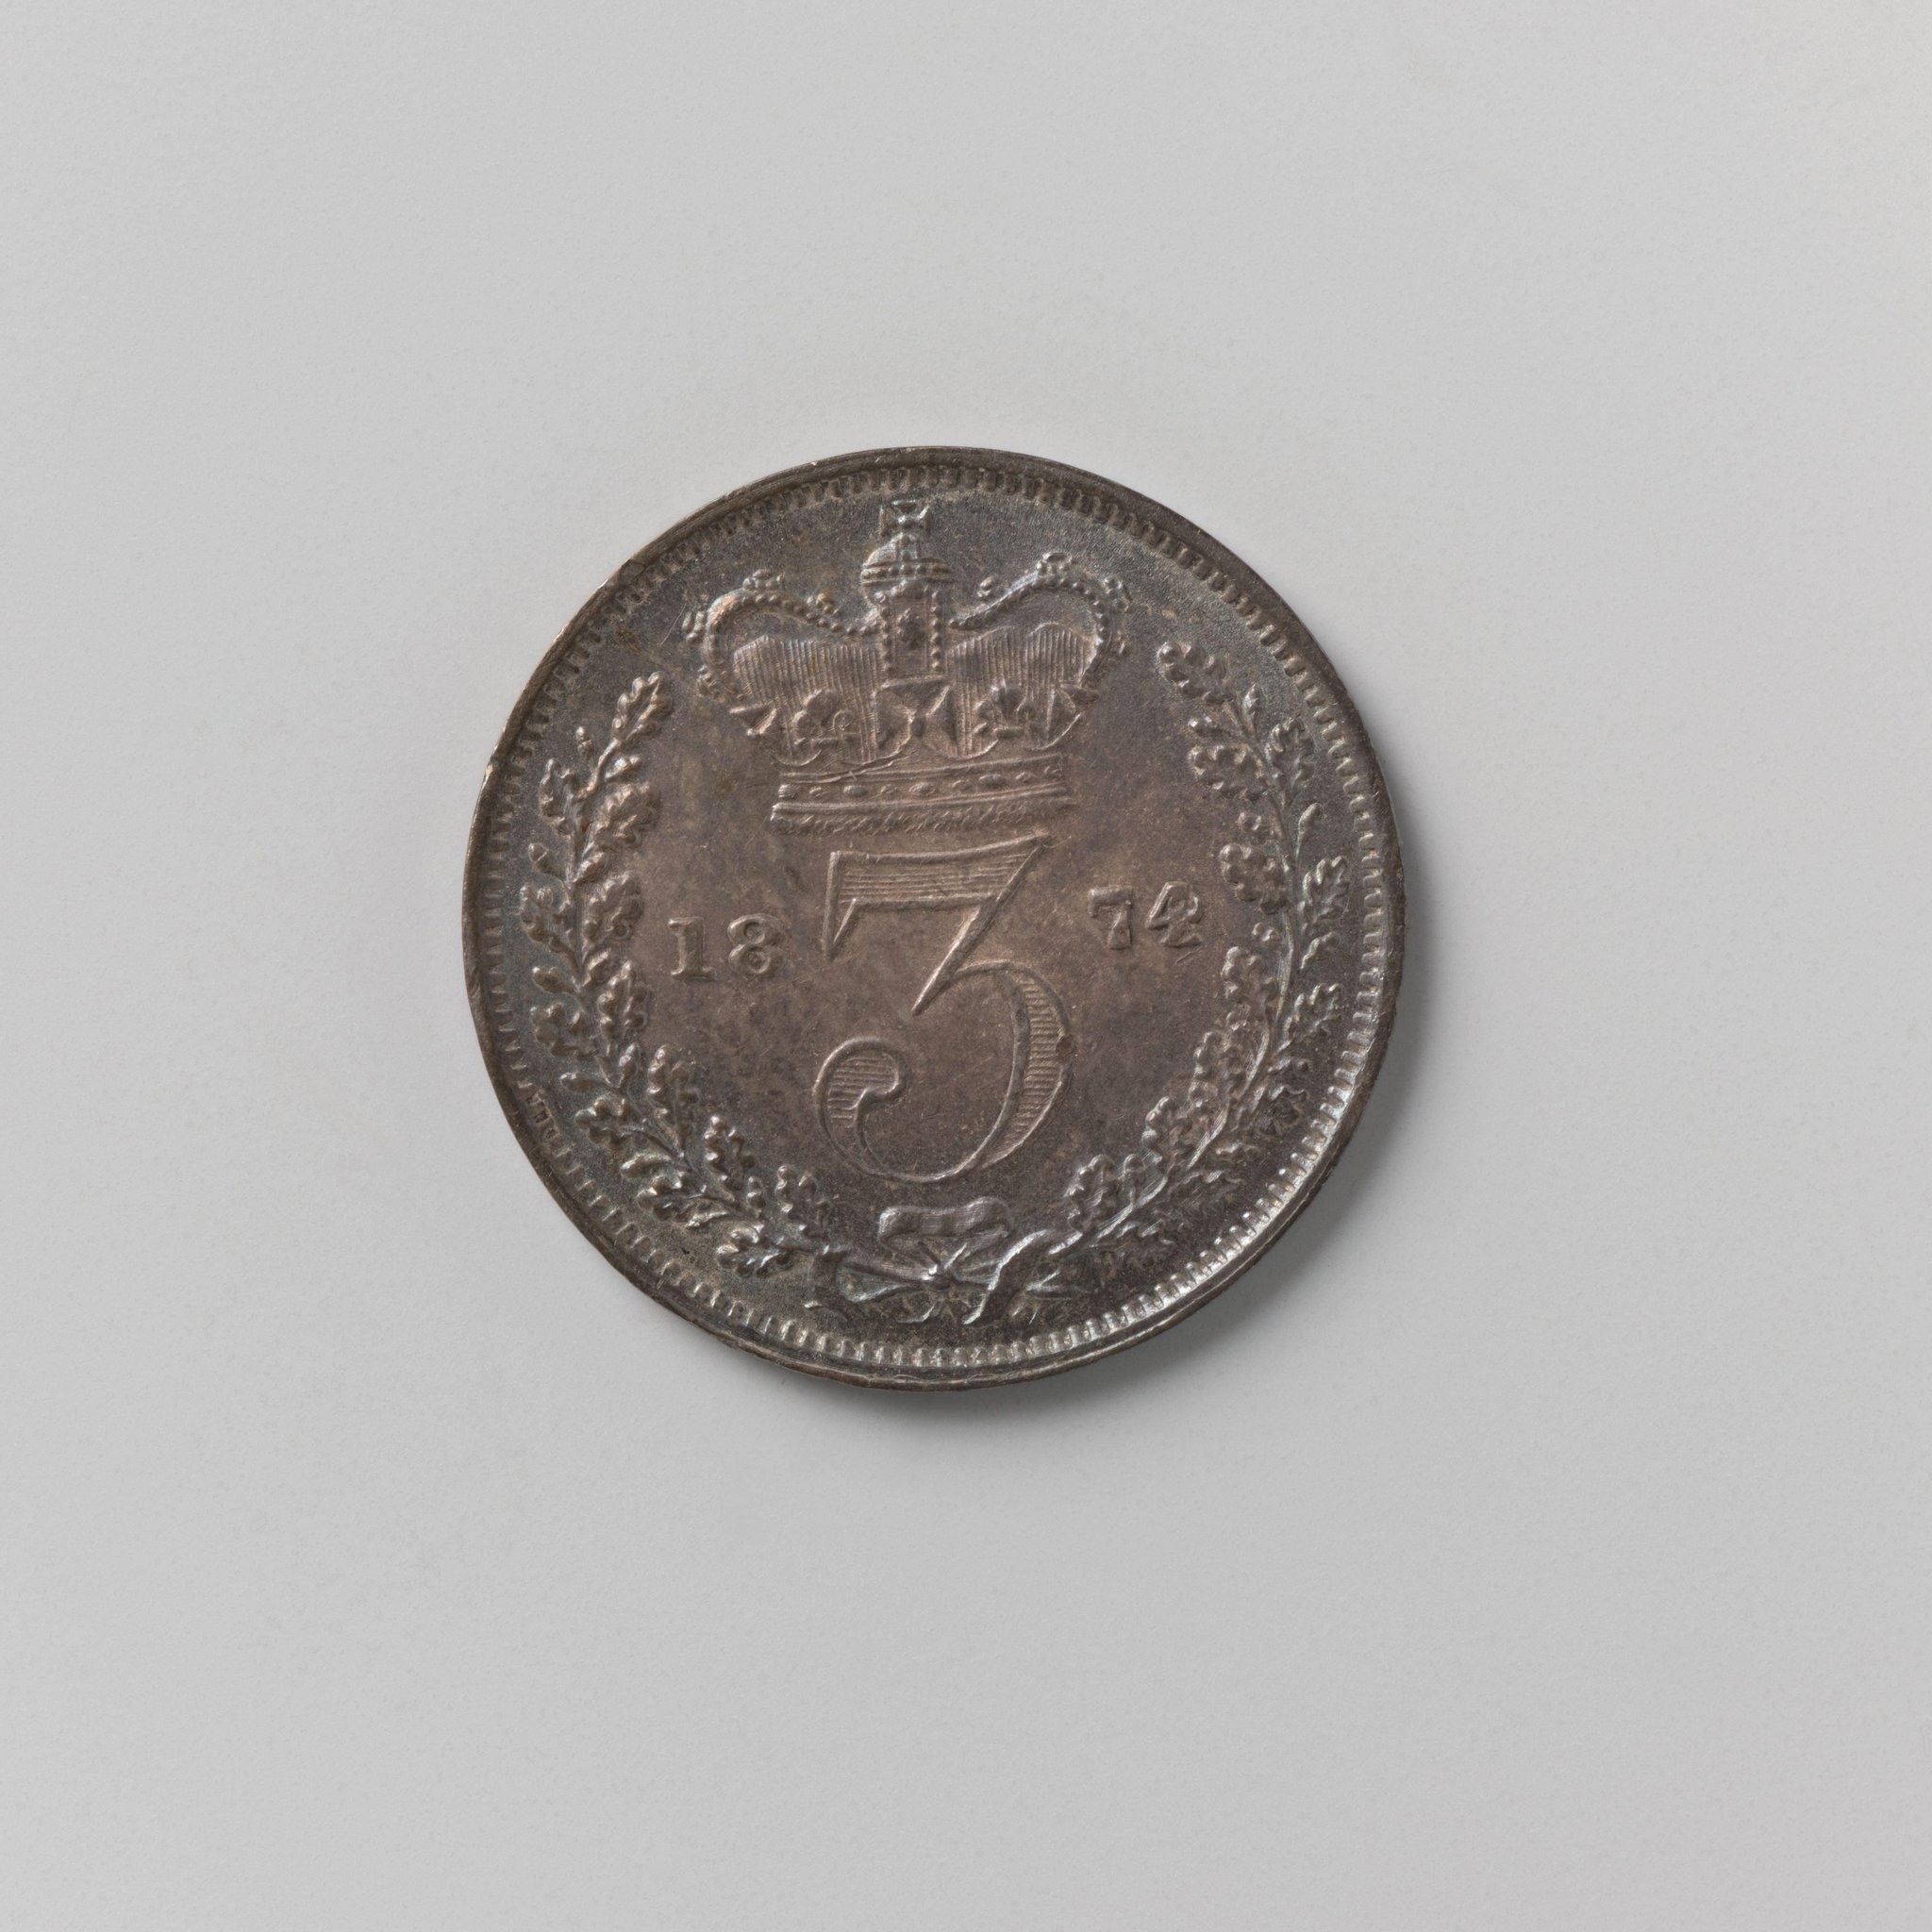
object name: coin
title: 3 pence uit Engeland van Victoria, 1874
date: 1874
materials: silver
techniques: striking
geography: london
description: Zilveren munt. Voorzijde: gekroond hoofd van de koningin naar links [young head]. Keerzijde: binnen twee samengebonden eikentakken tussen jaartal waarde-aanduiding. Daarboven kroon. Gladdde rand.